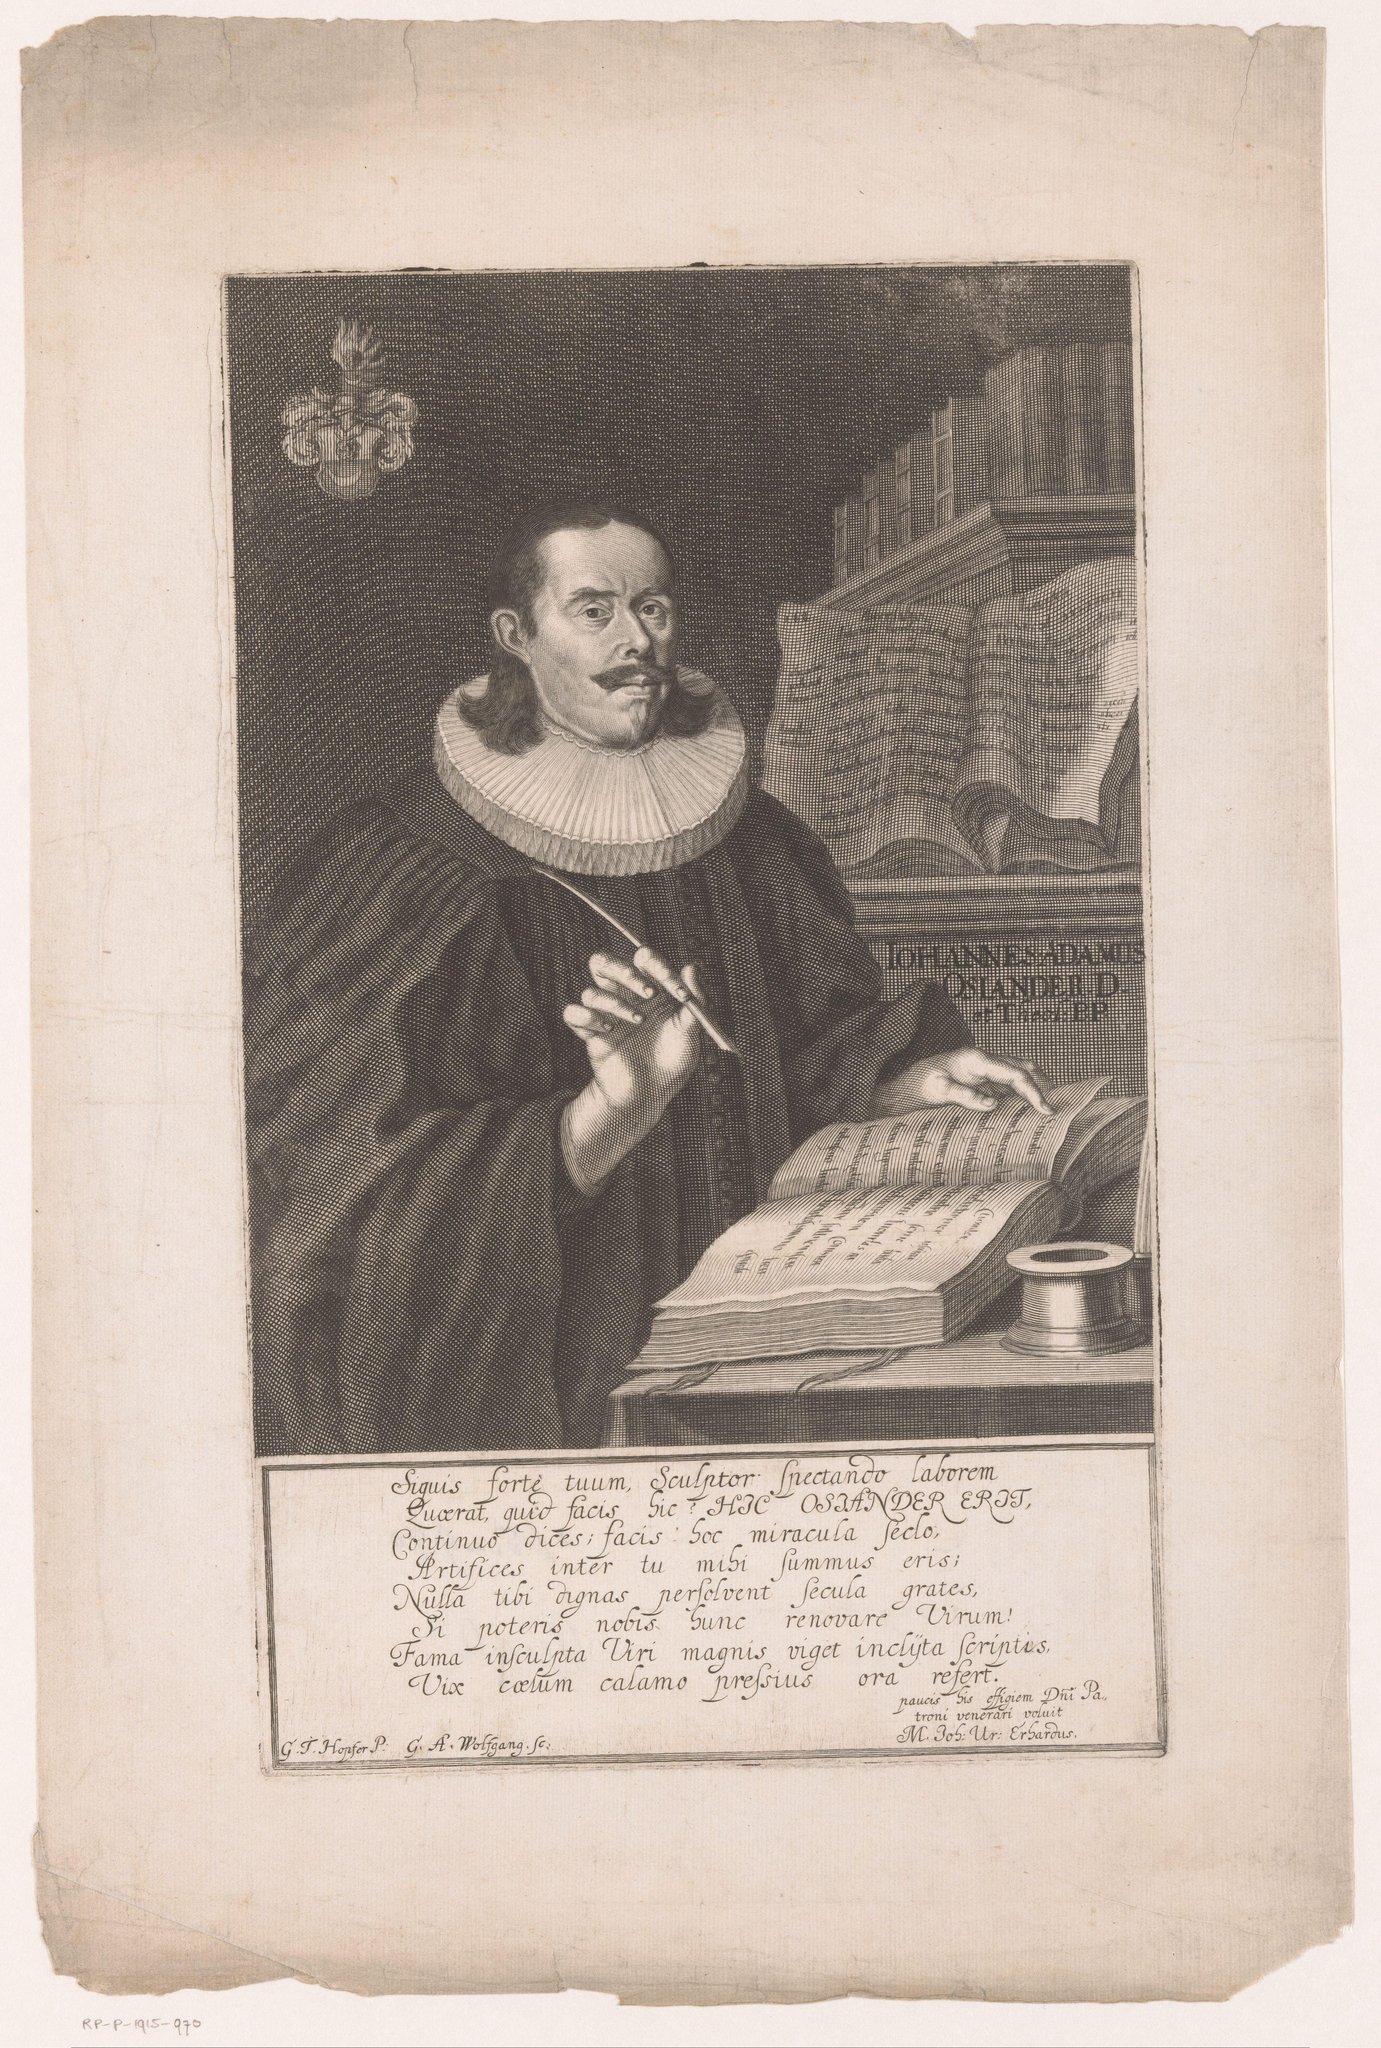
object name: print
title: Portret van Johann Adam Osiander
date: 1657-1716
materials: paper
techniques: engraving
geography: germany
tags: johann adam osiander, writing tools, historical persons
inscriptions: collector's mark: Lugt 2228